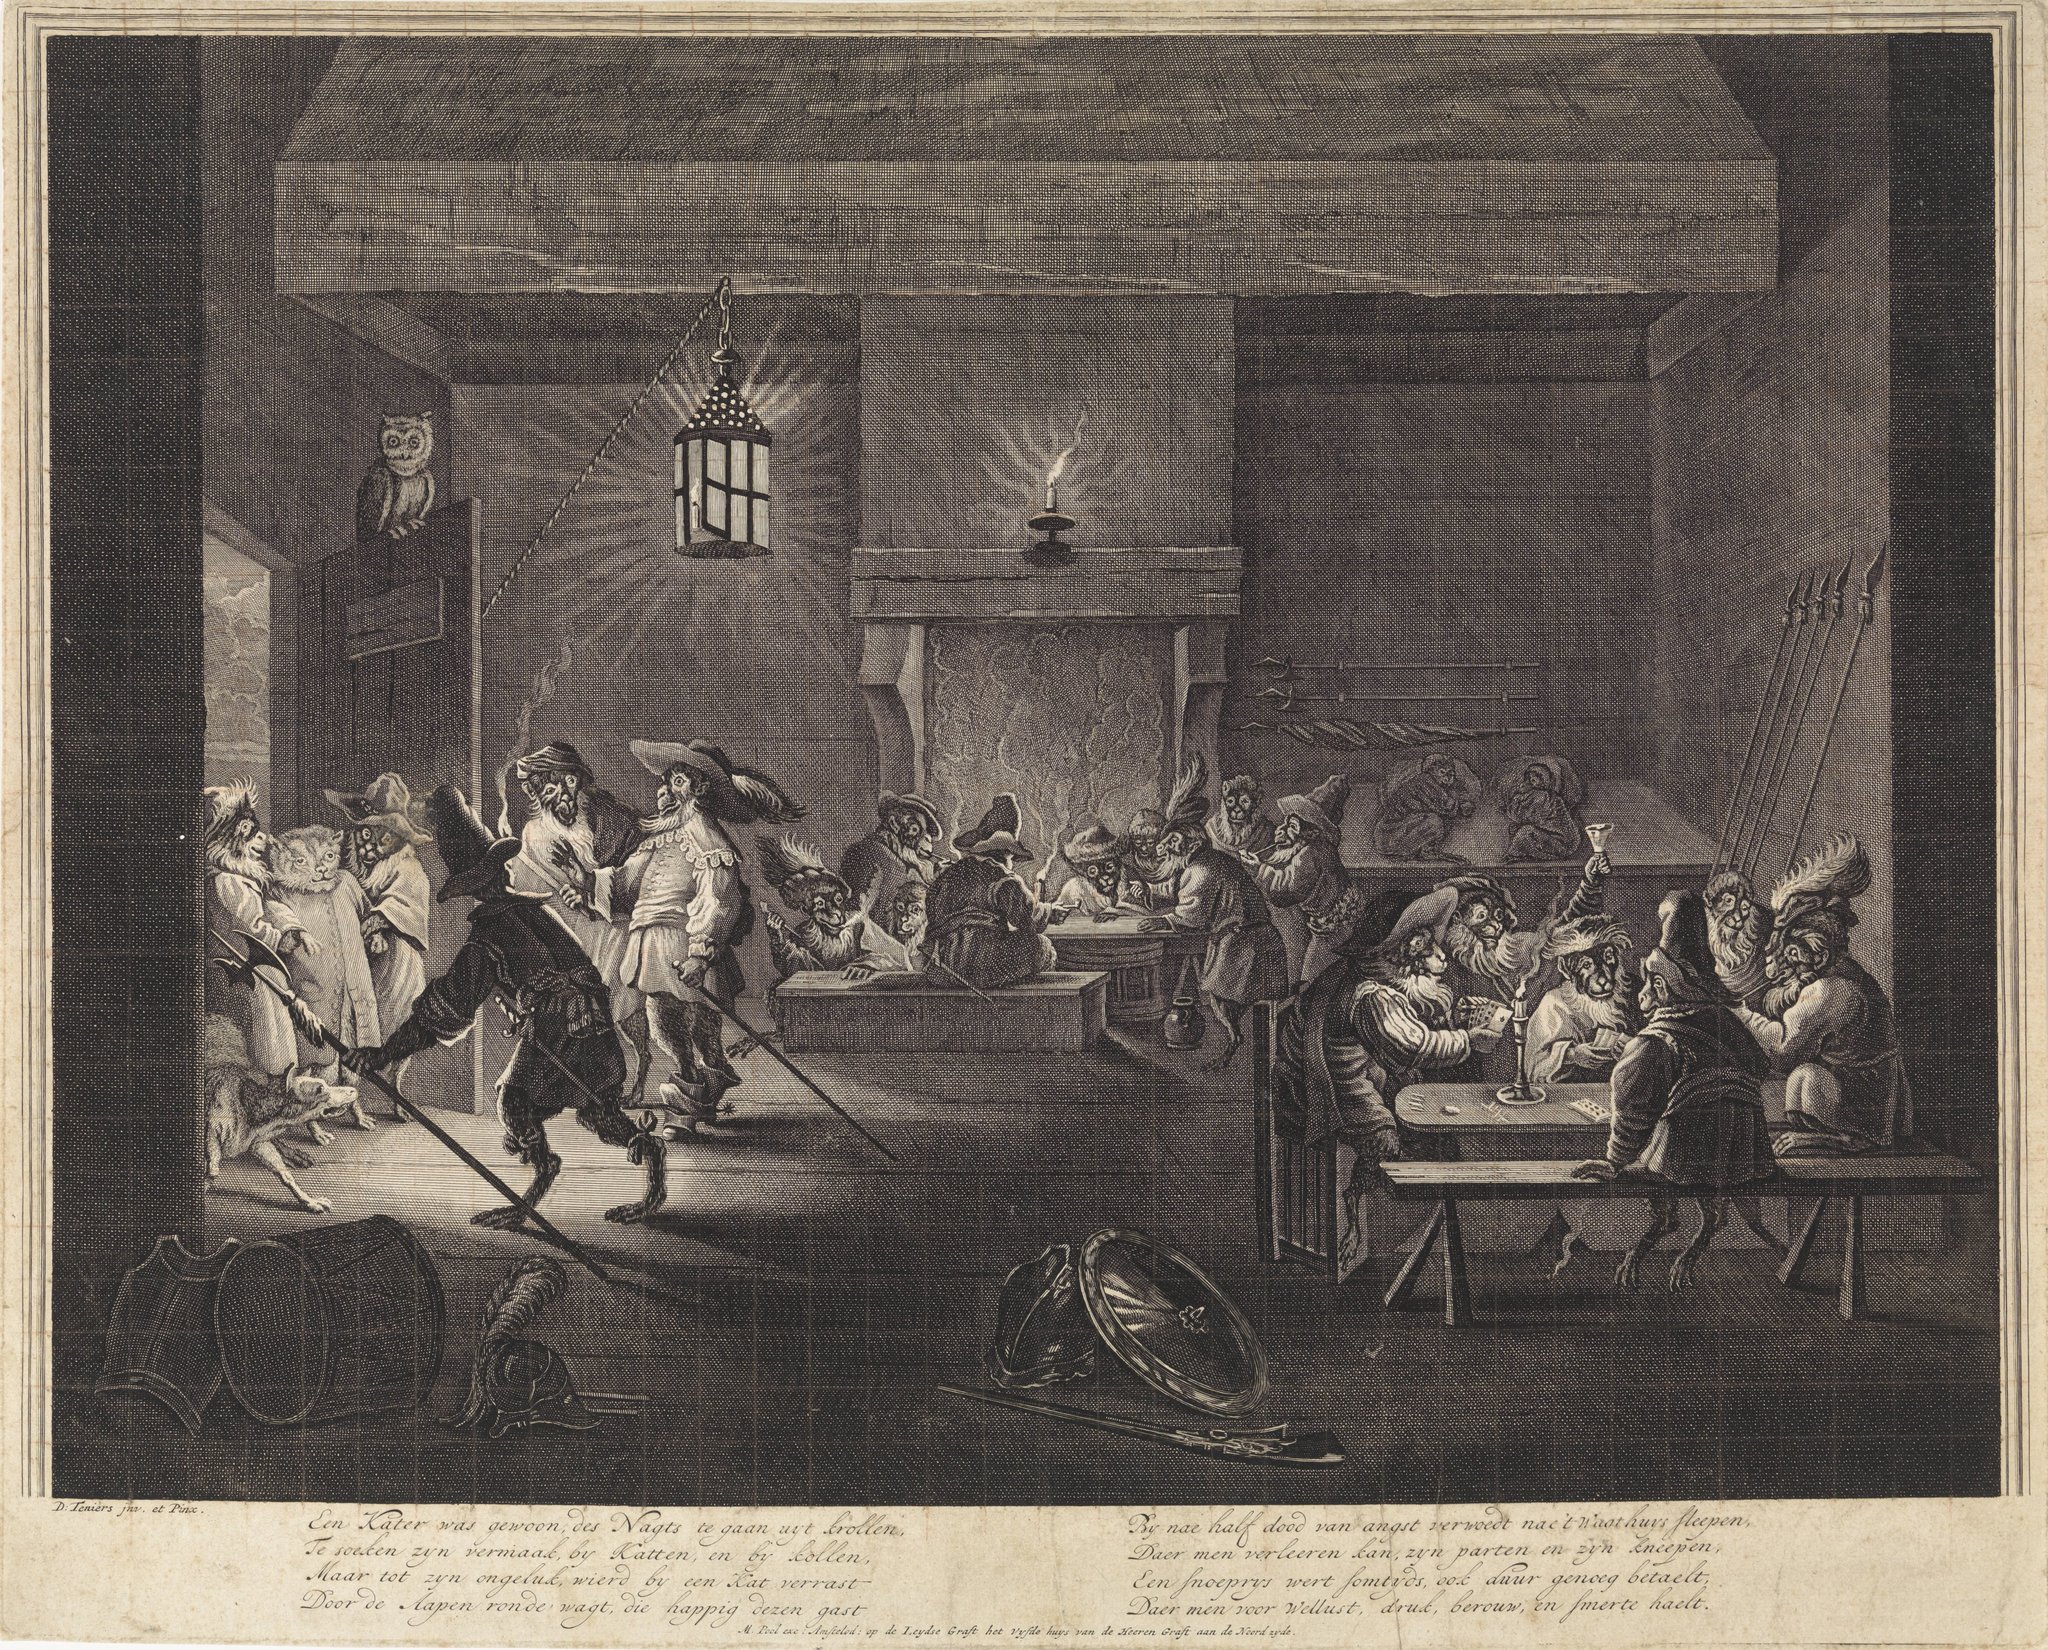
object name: print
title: Wachtlokaal met apen, ca. 1720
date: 1710-1730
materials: paper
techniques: engraving, etching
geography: amsterdam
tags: monkeys, apes, animals acting as human beings, in the guard-room, 'kortegaard'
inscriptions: collector's mark: Lugt 240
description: Wachtlokaal of kortegaard waarin apen als soldaten kaarten en dobbelen en drinken en roken, ca. 1720. Bij de deur wordt een kat door twee wachten binnengebracht. In het onderschrift twee vierregelige verzen.